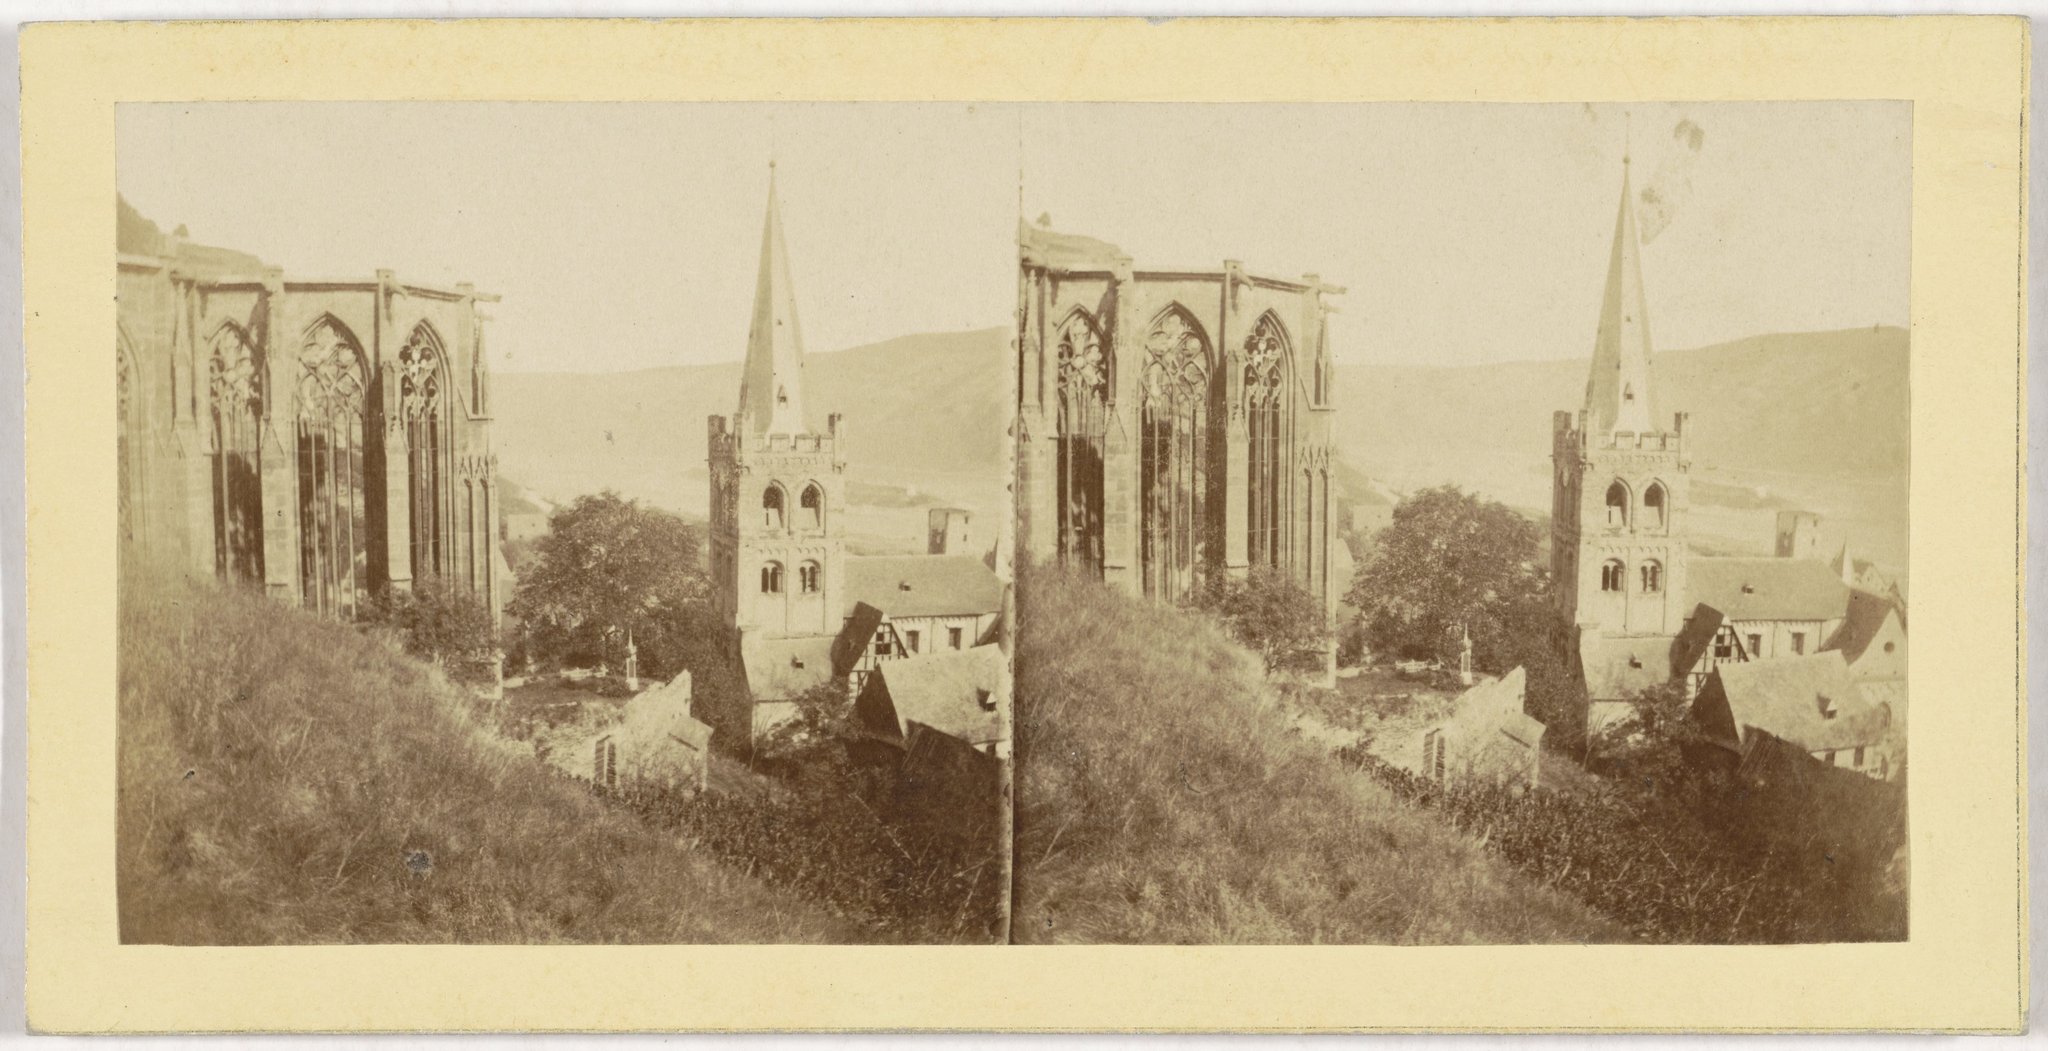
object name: stereograph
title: Bords du Rhin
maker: Anonymous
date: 1861-1870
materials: cardboard, paper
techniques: albumen print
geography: bacharach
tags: ruin of church, monastery, etc., parts of church exterior and annexes: tower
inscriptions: inscription: ‘6’, number: ‘No 87’